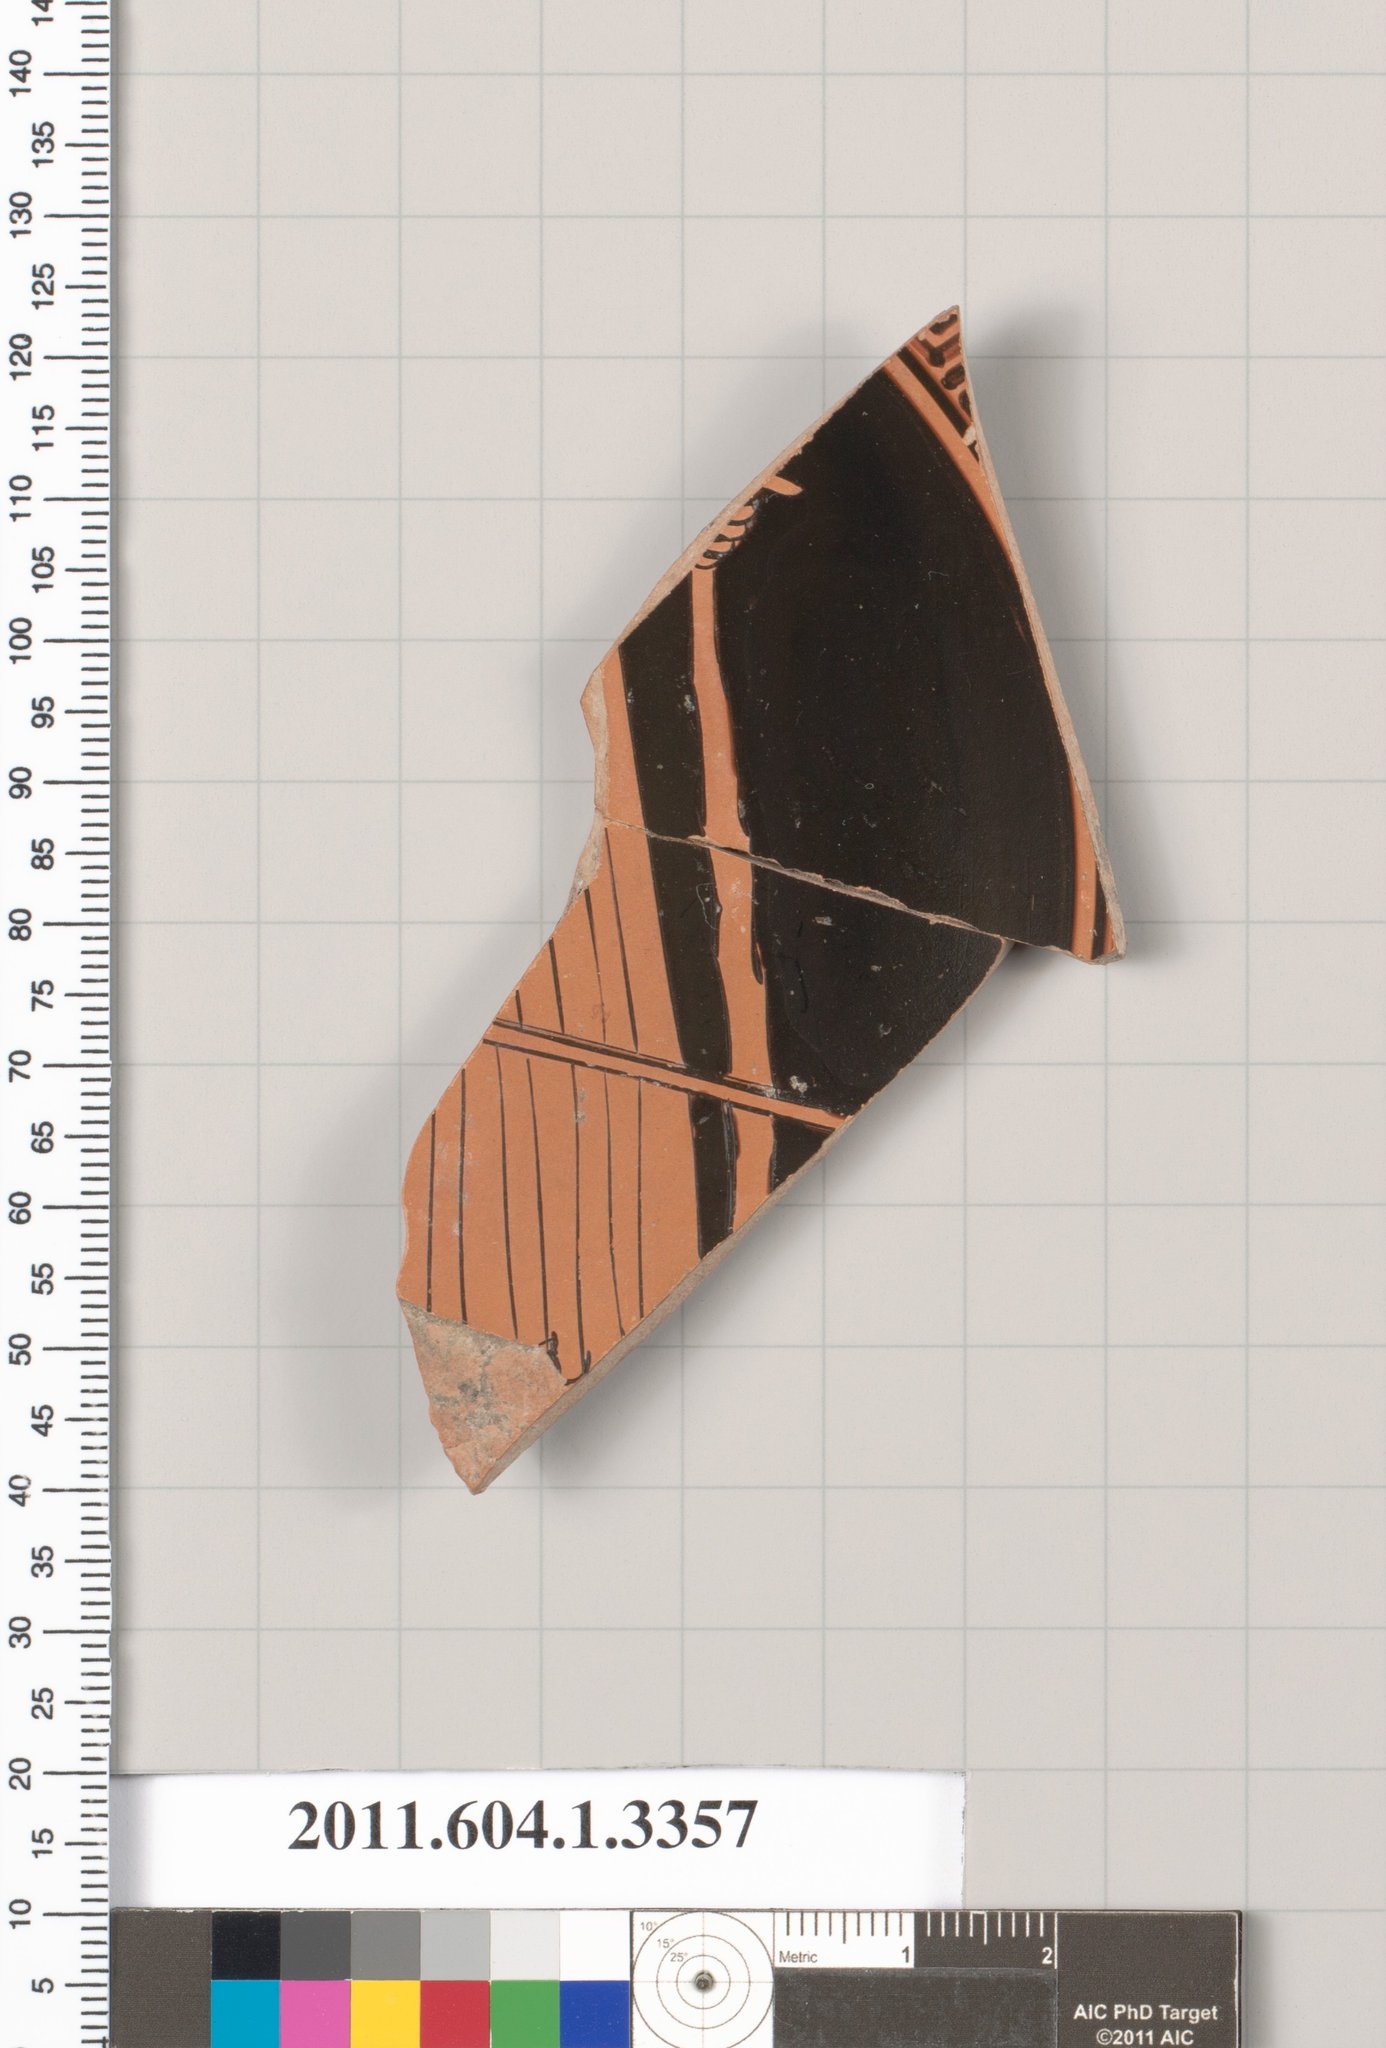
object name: kylix fragment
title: Terracotta fragment of a kylix (drinking cup)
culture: greek, attic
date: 475-451 BCE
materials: terracotta